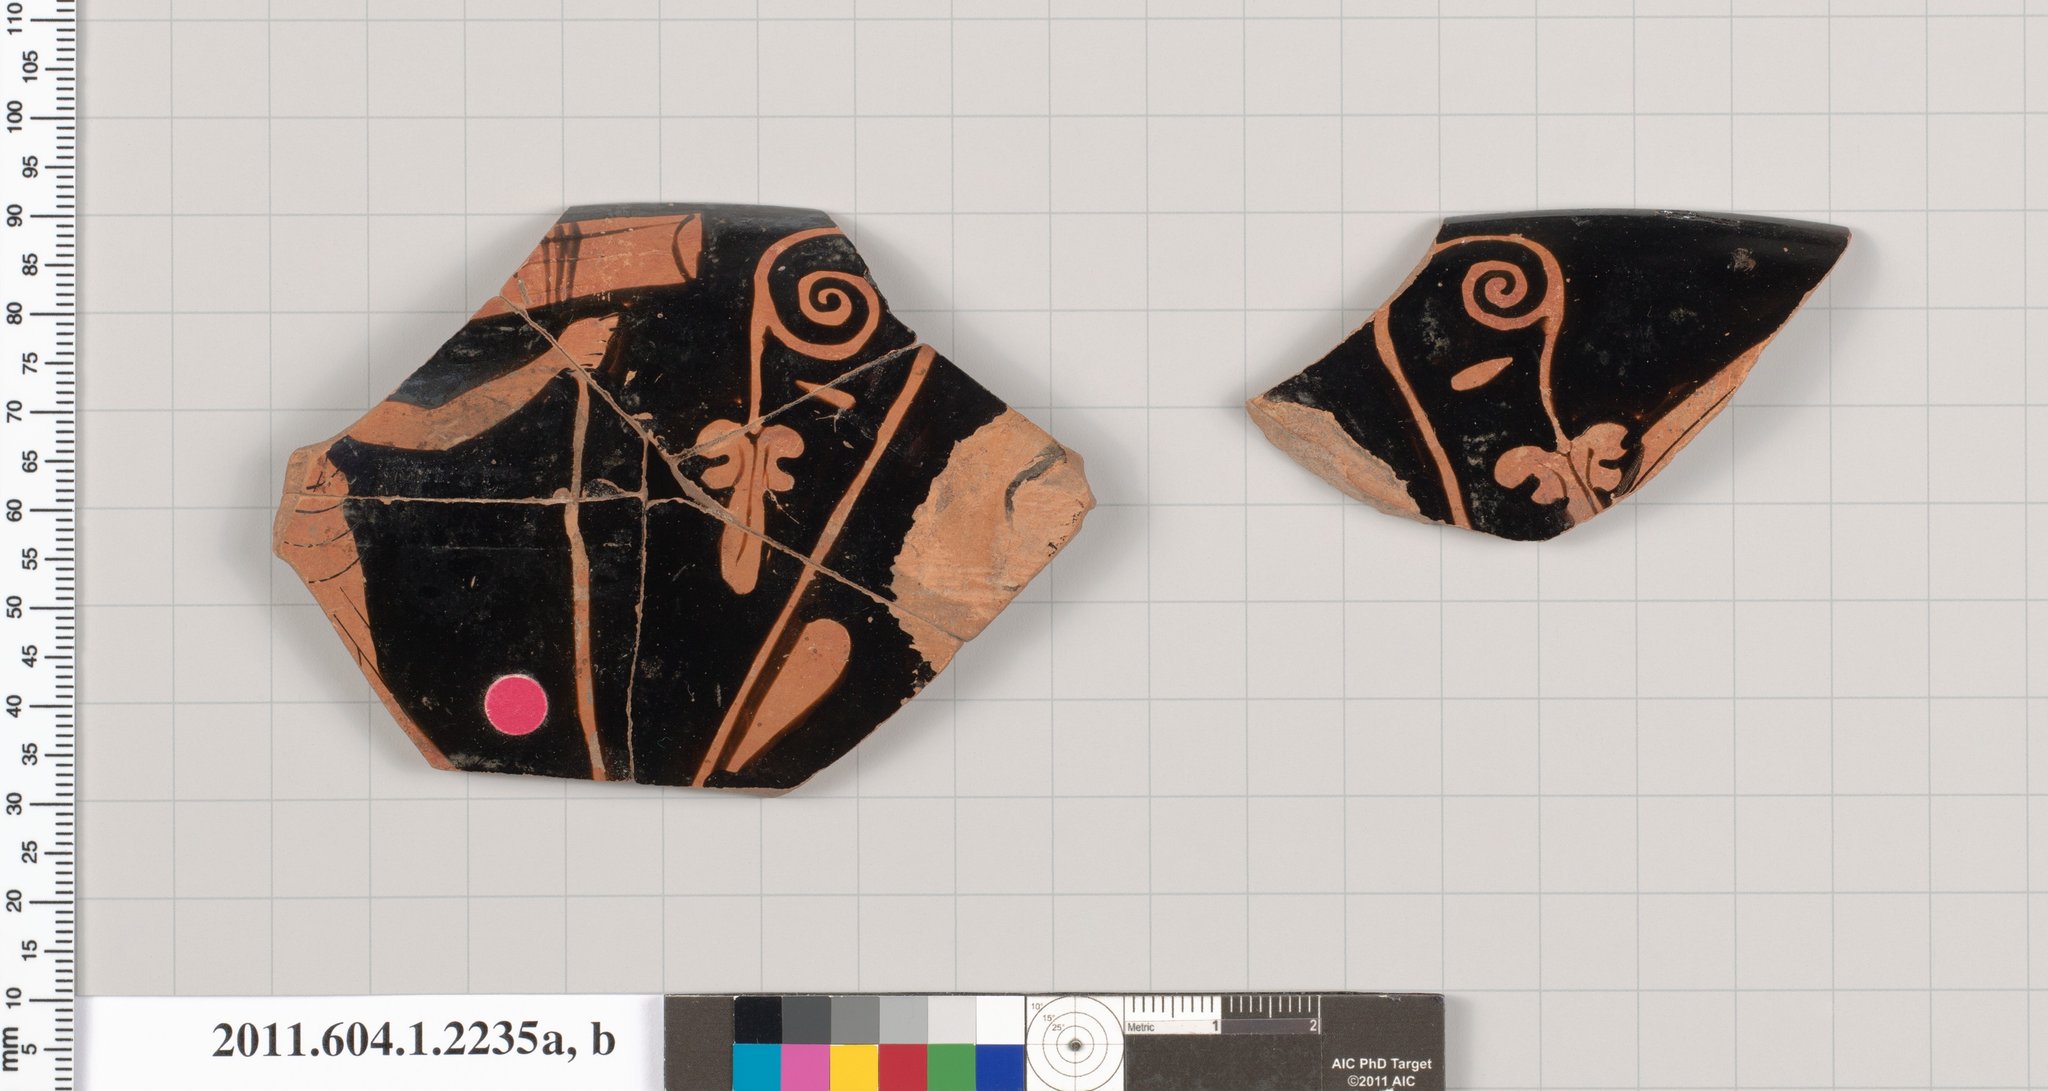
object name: kylix fragment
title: Terracotta rim fragment of a kylix (drinking cup)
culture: greek, attic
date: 460-450 BCE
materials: terracotta